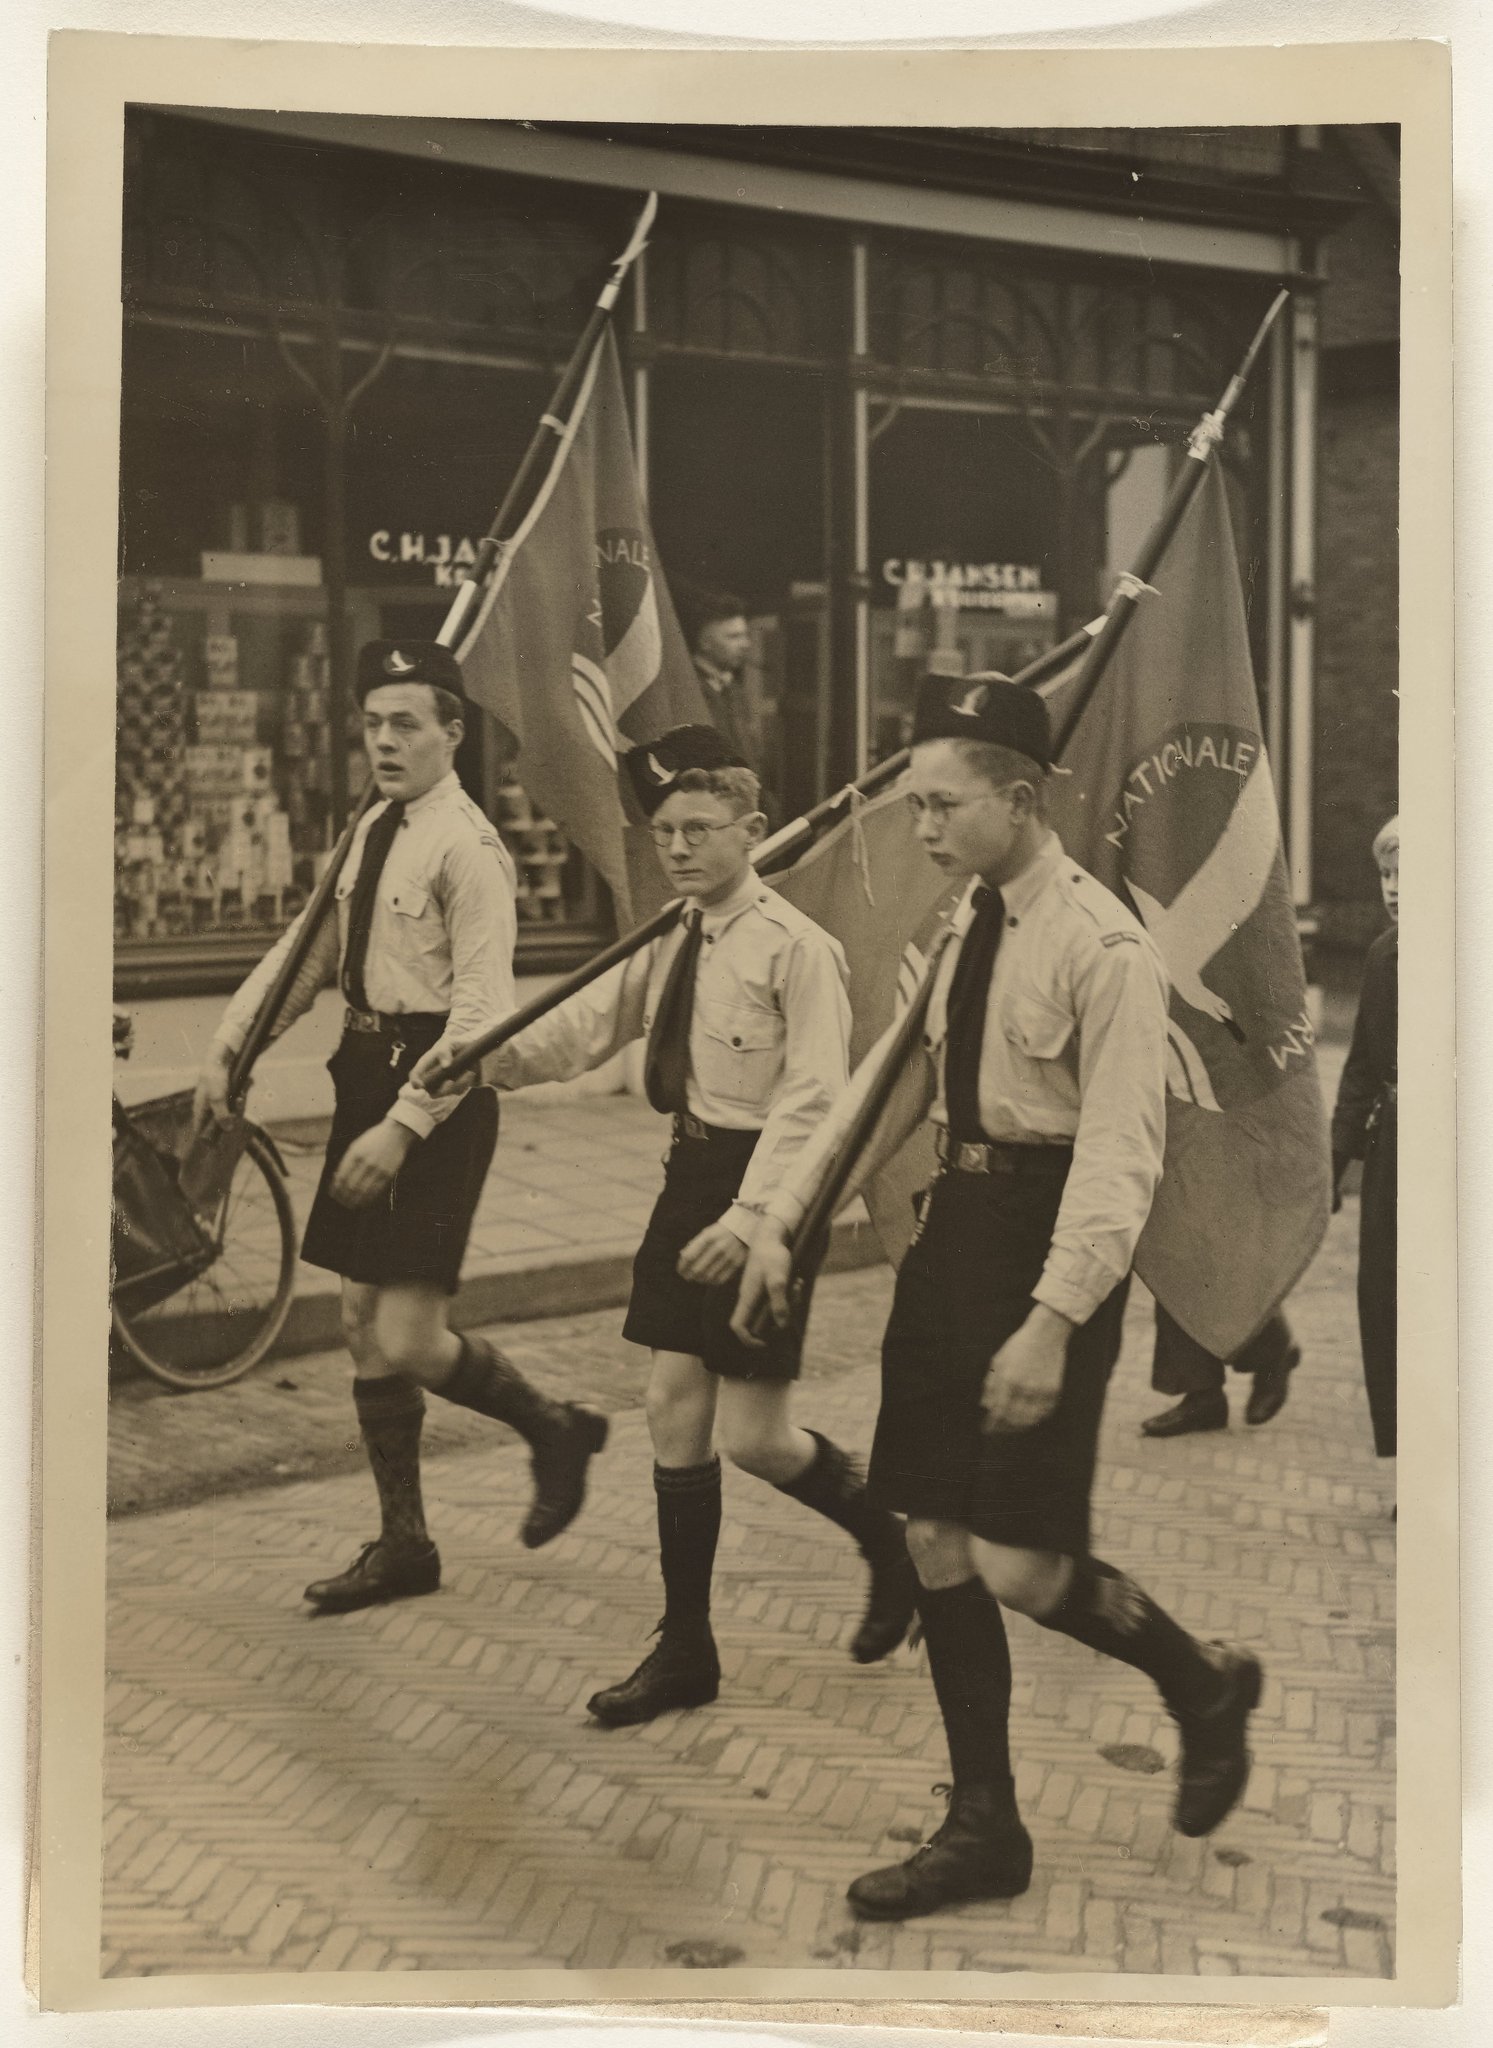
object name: photograph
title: Drie jongens van de Nationale Jeugdstorm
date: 1938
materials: photographic support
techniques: photography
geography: baarn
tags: the hague, juliana of the netherlands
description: Een oefen-optocht van kinderen, drie jongens met een vlag van de Nationale Jeugdstorm, de jeugdafdeling van de NSB, door de straten van Baarn.